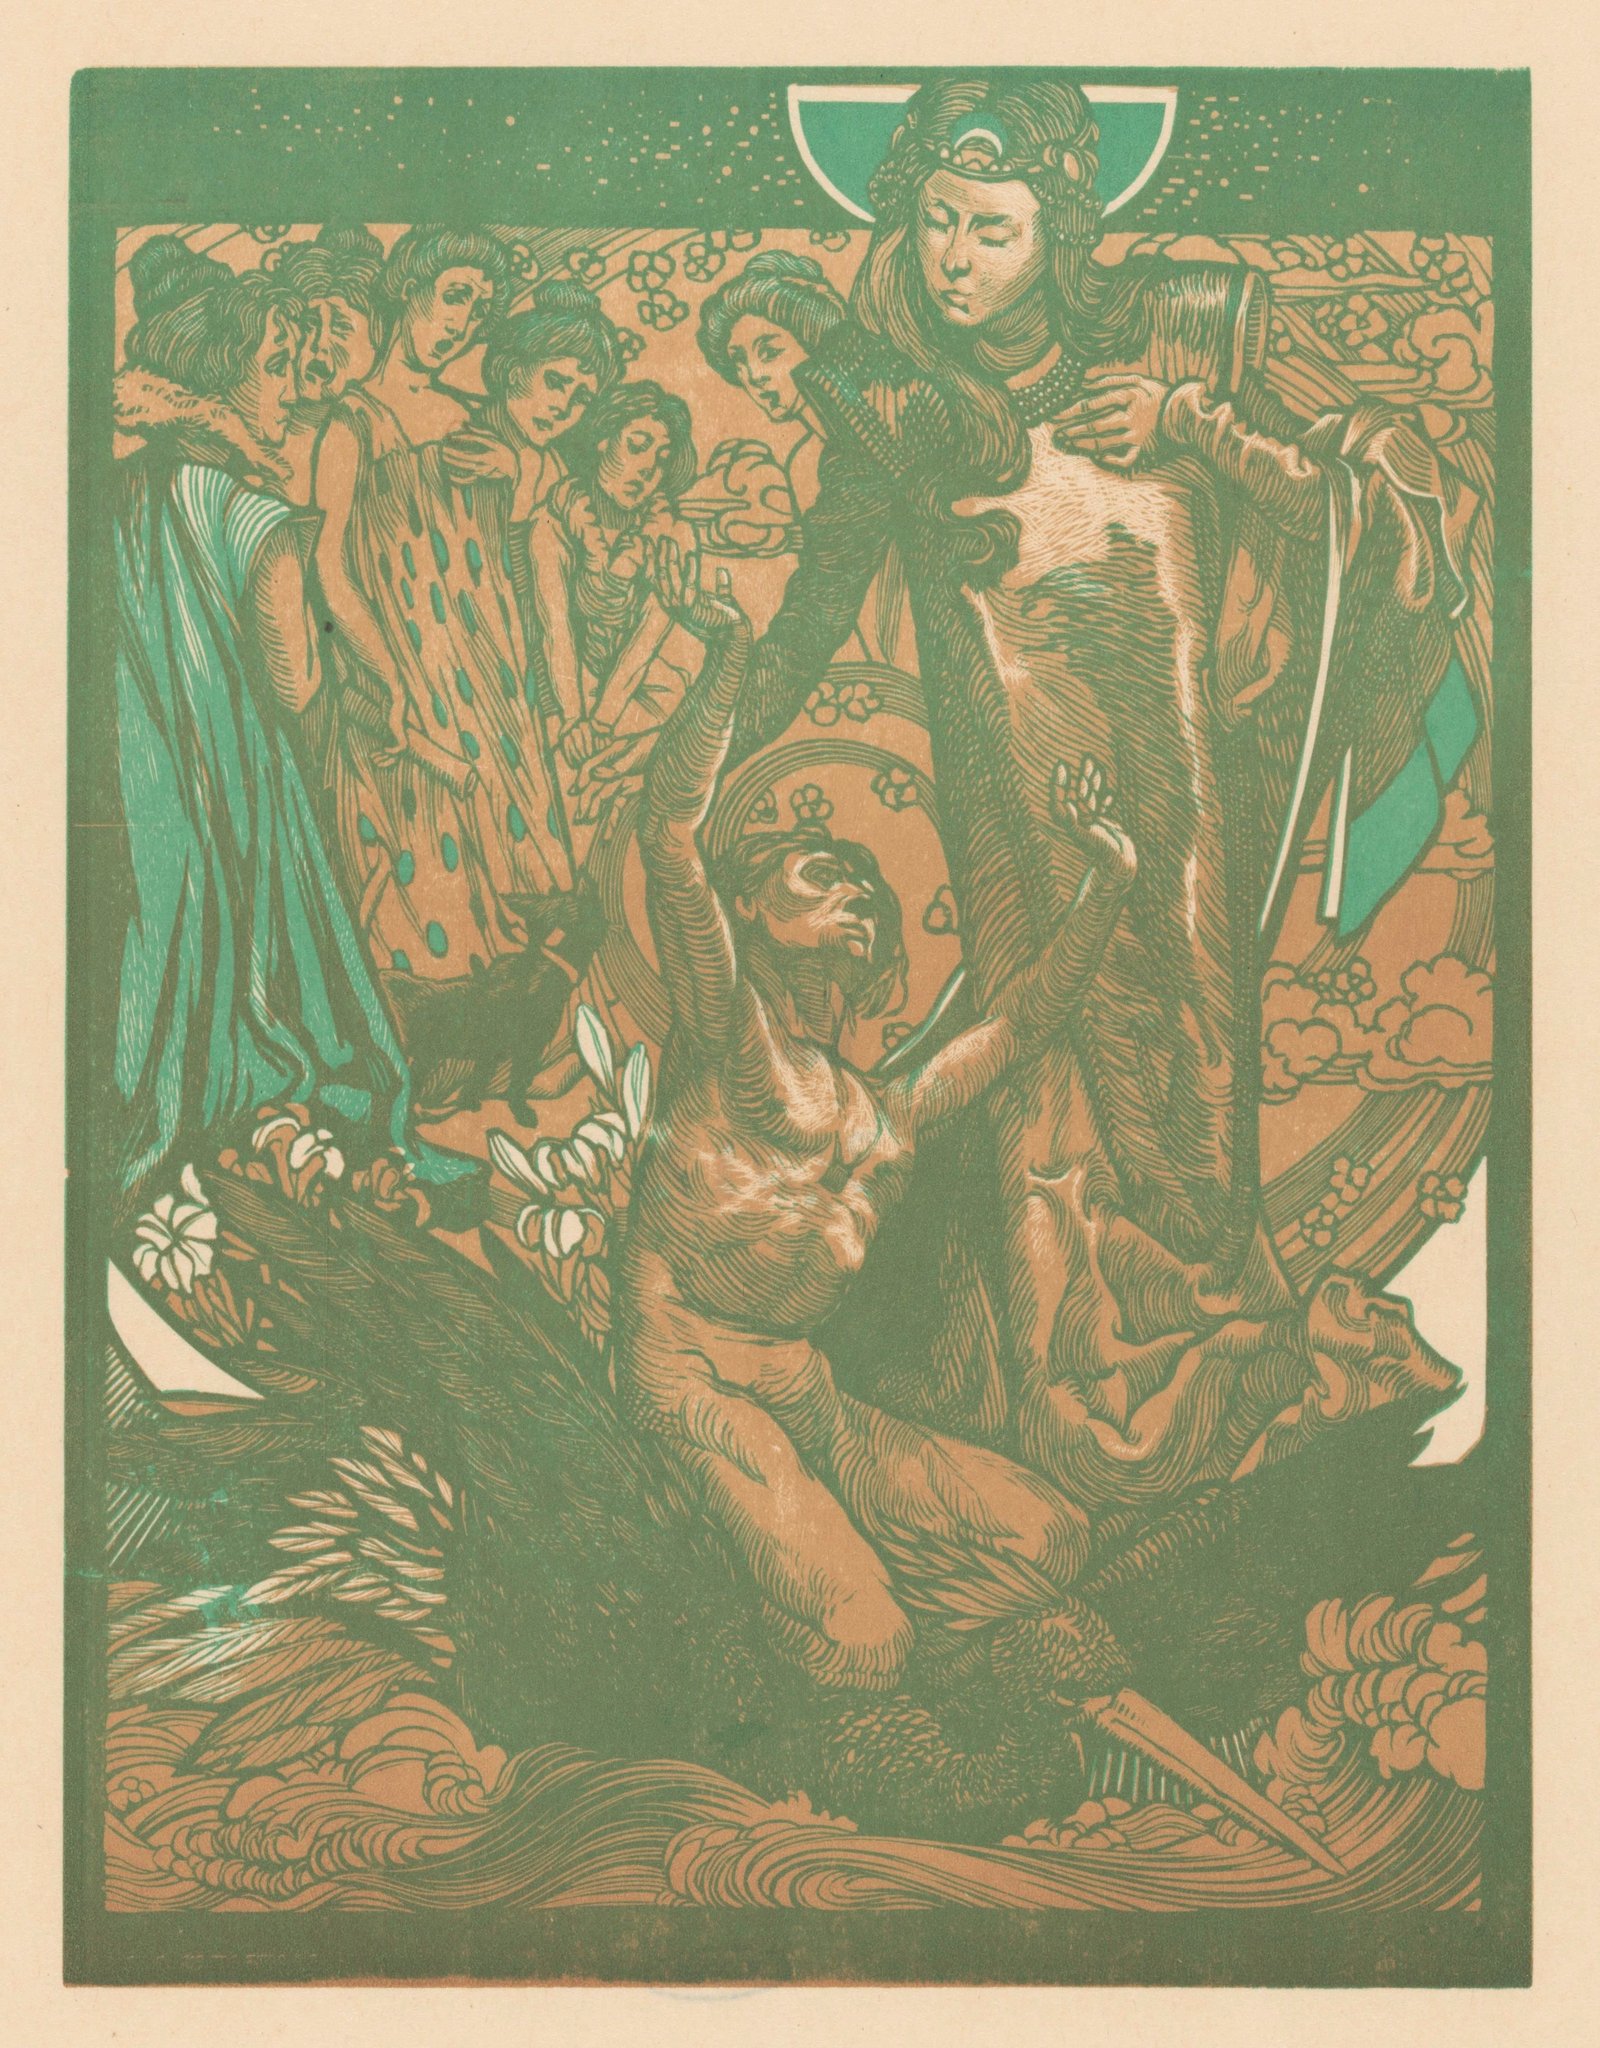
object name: print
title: Vrouwenfiguren met man op rug van vogel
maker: johannes josephus aarts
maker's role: draughtsman, print maker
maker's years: 1871-1934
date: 1881-1934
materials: paper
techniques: woodcut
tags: flying on or with the aid of animal(s), flowers, cat, birds, surrealia, surrealistic representations, lohengrin or the knight of the swan, in german legend the son of percival or parsifal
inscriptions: collector's mark: Lugt 2166, collector's mark: Lugt 2228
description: Een naakte man vliegt op de rug van een vogel. Hij heft zijn armen ten hemel. Hij wordt van boven bekeken door verschillende vrouwen gekleed in jurken. Er is een kat in hun midden. In de lucht zweven wolken en bloemen.